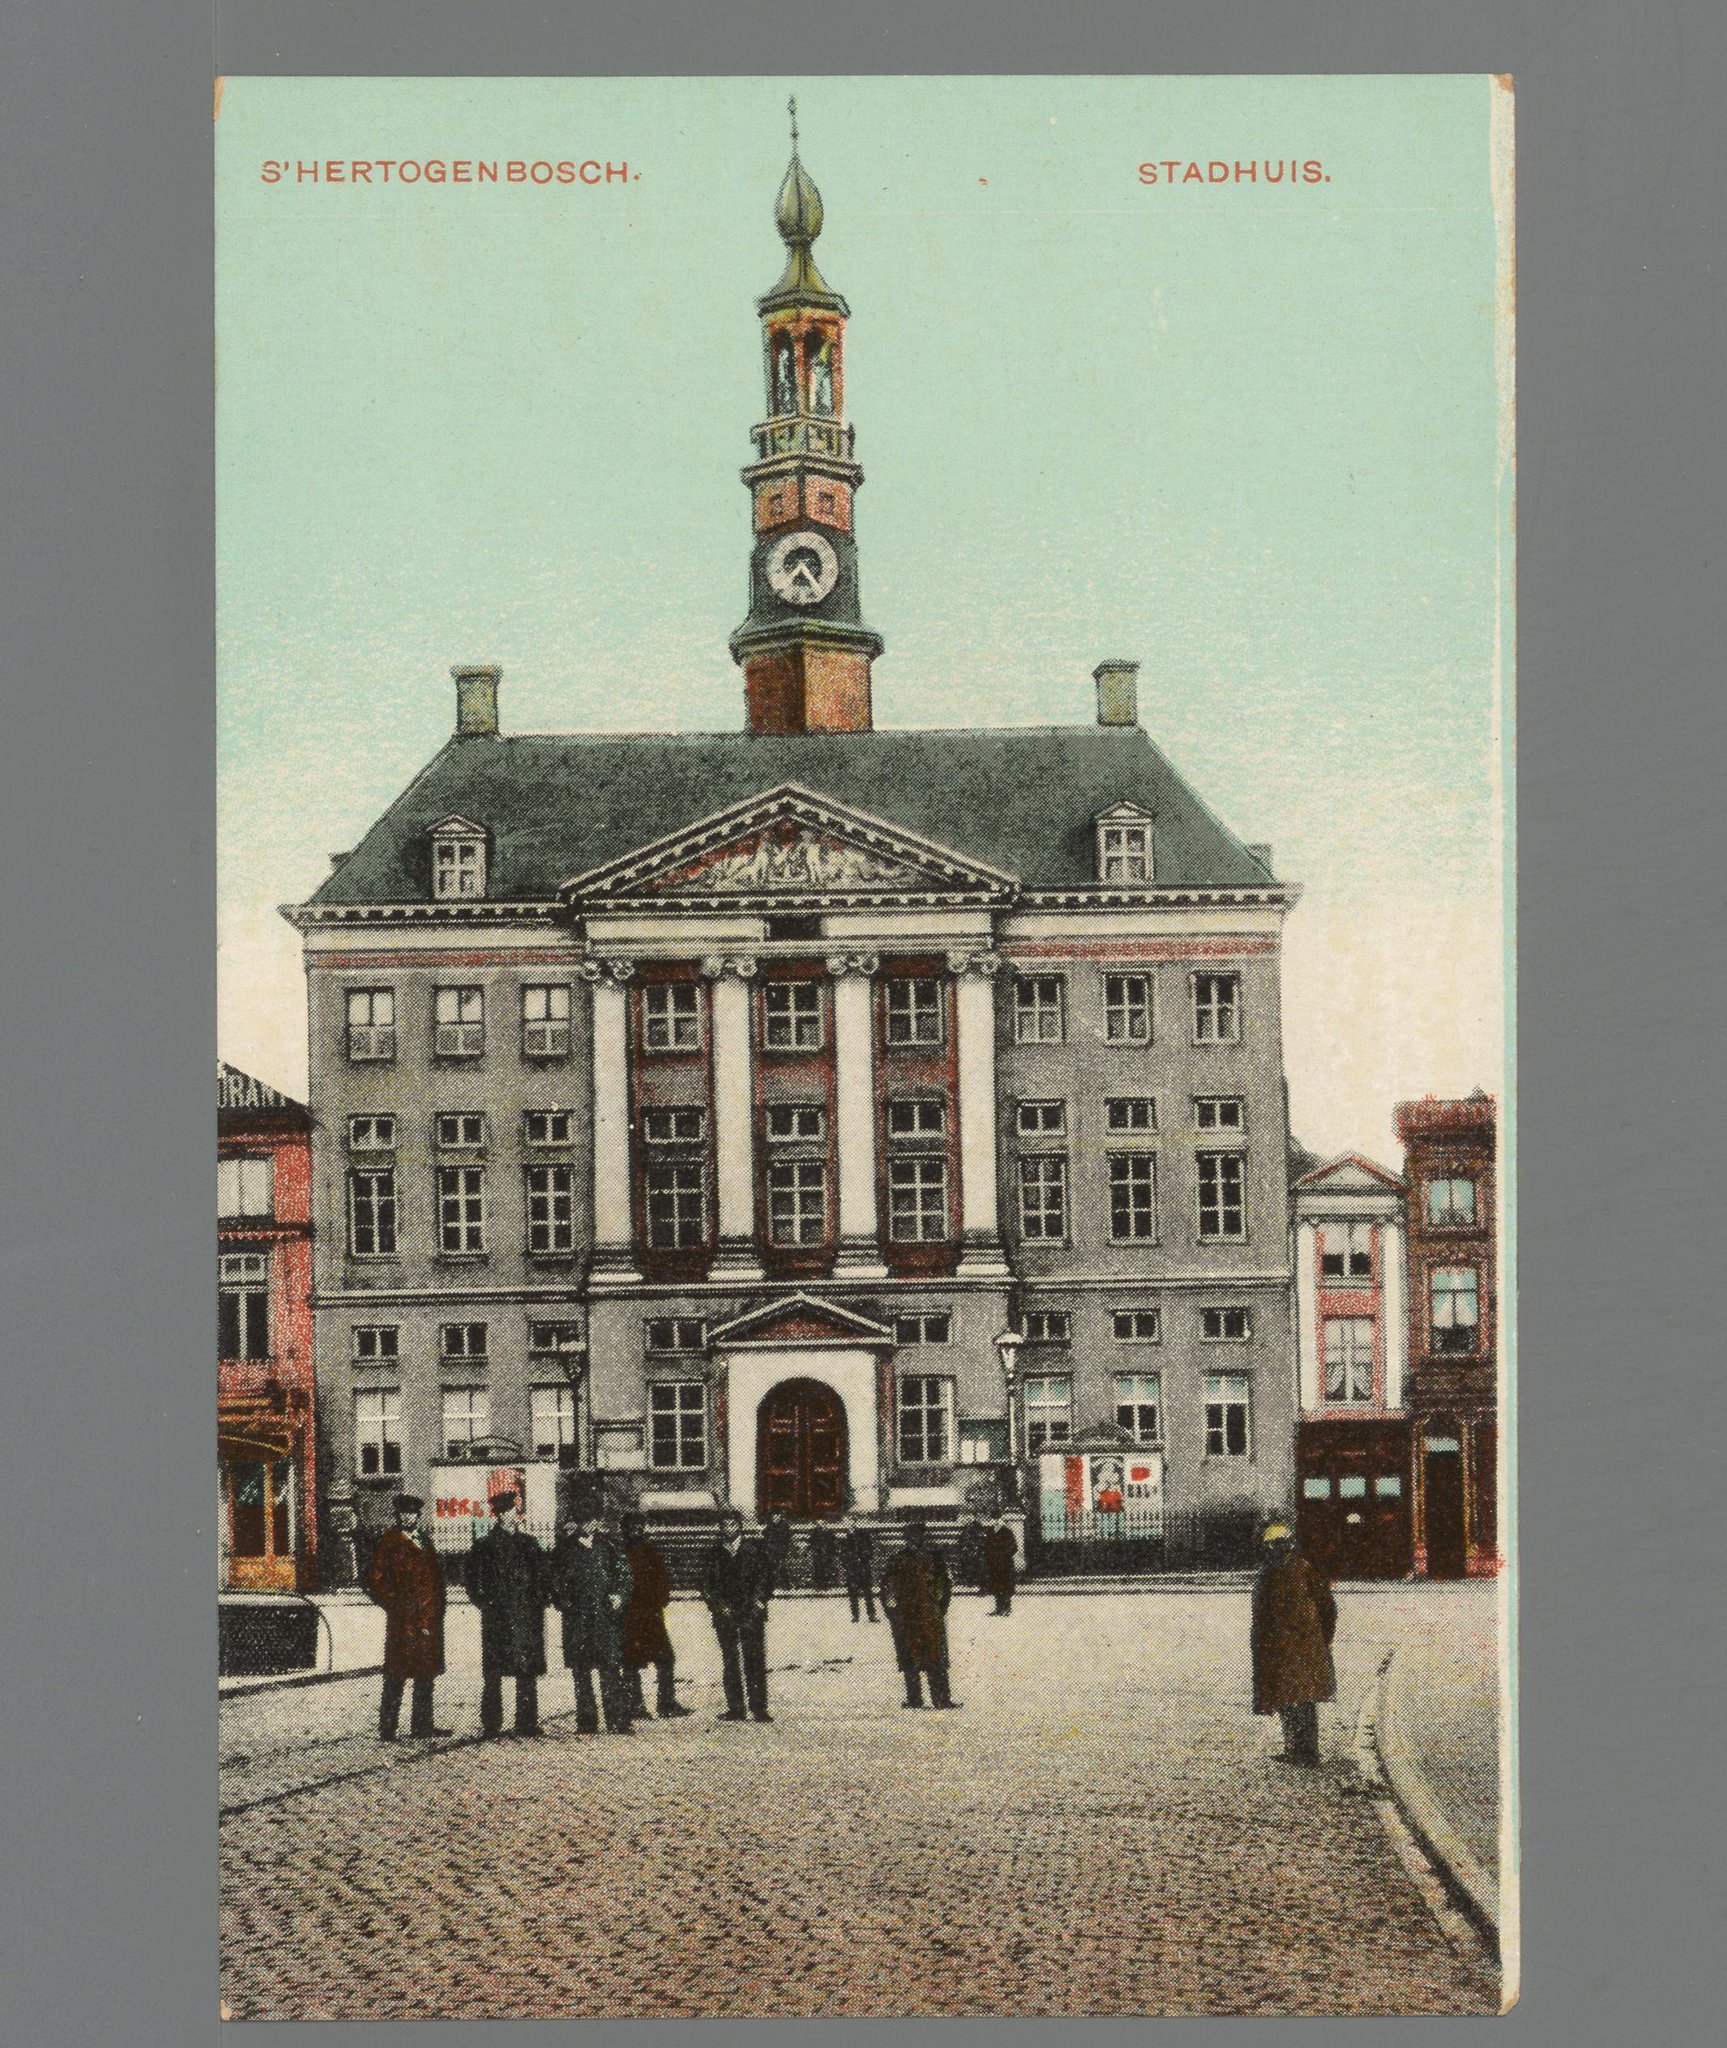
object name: photomechanical print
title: s'Hertogenbosch. Stadhuis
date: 1905-1909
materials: cardboard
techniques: lithograph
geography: amsterdam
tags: townhall